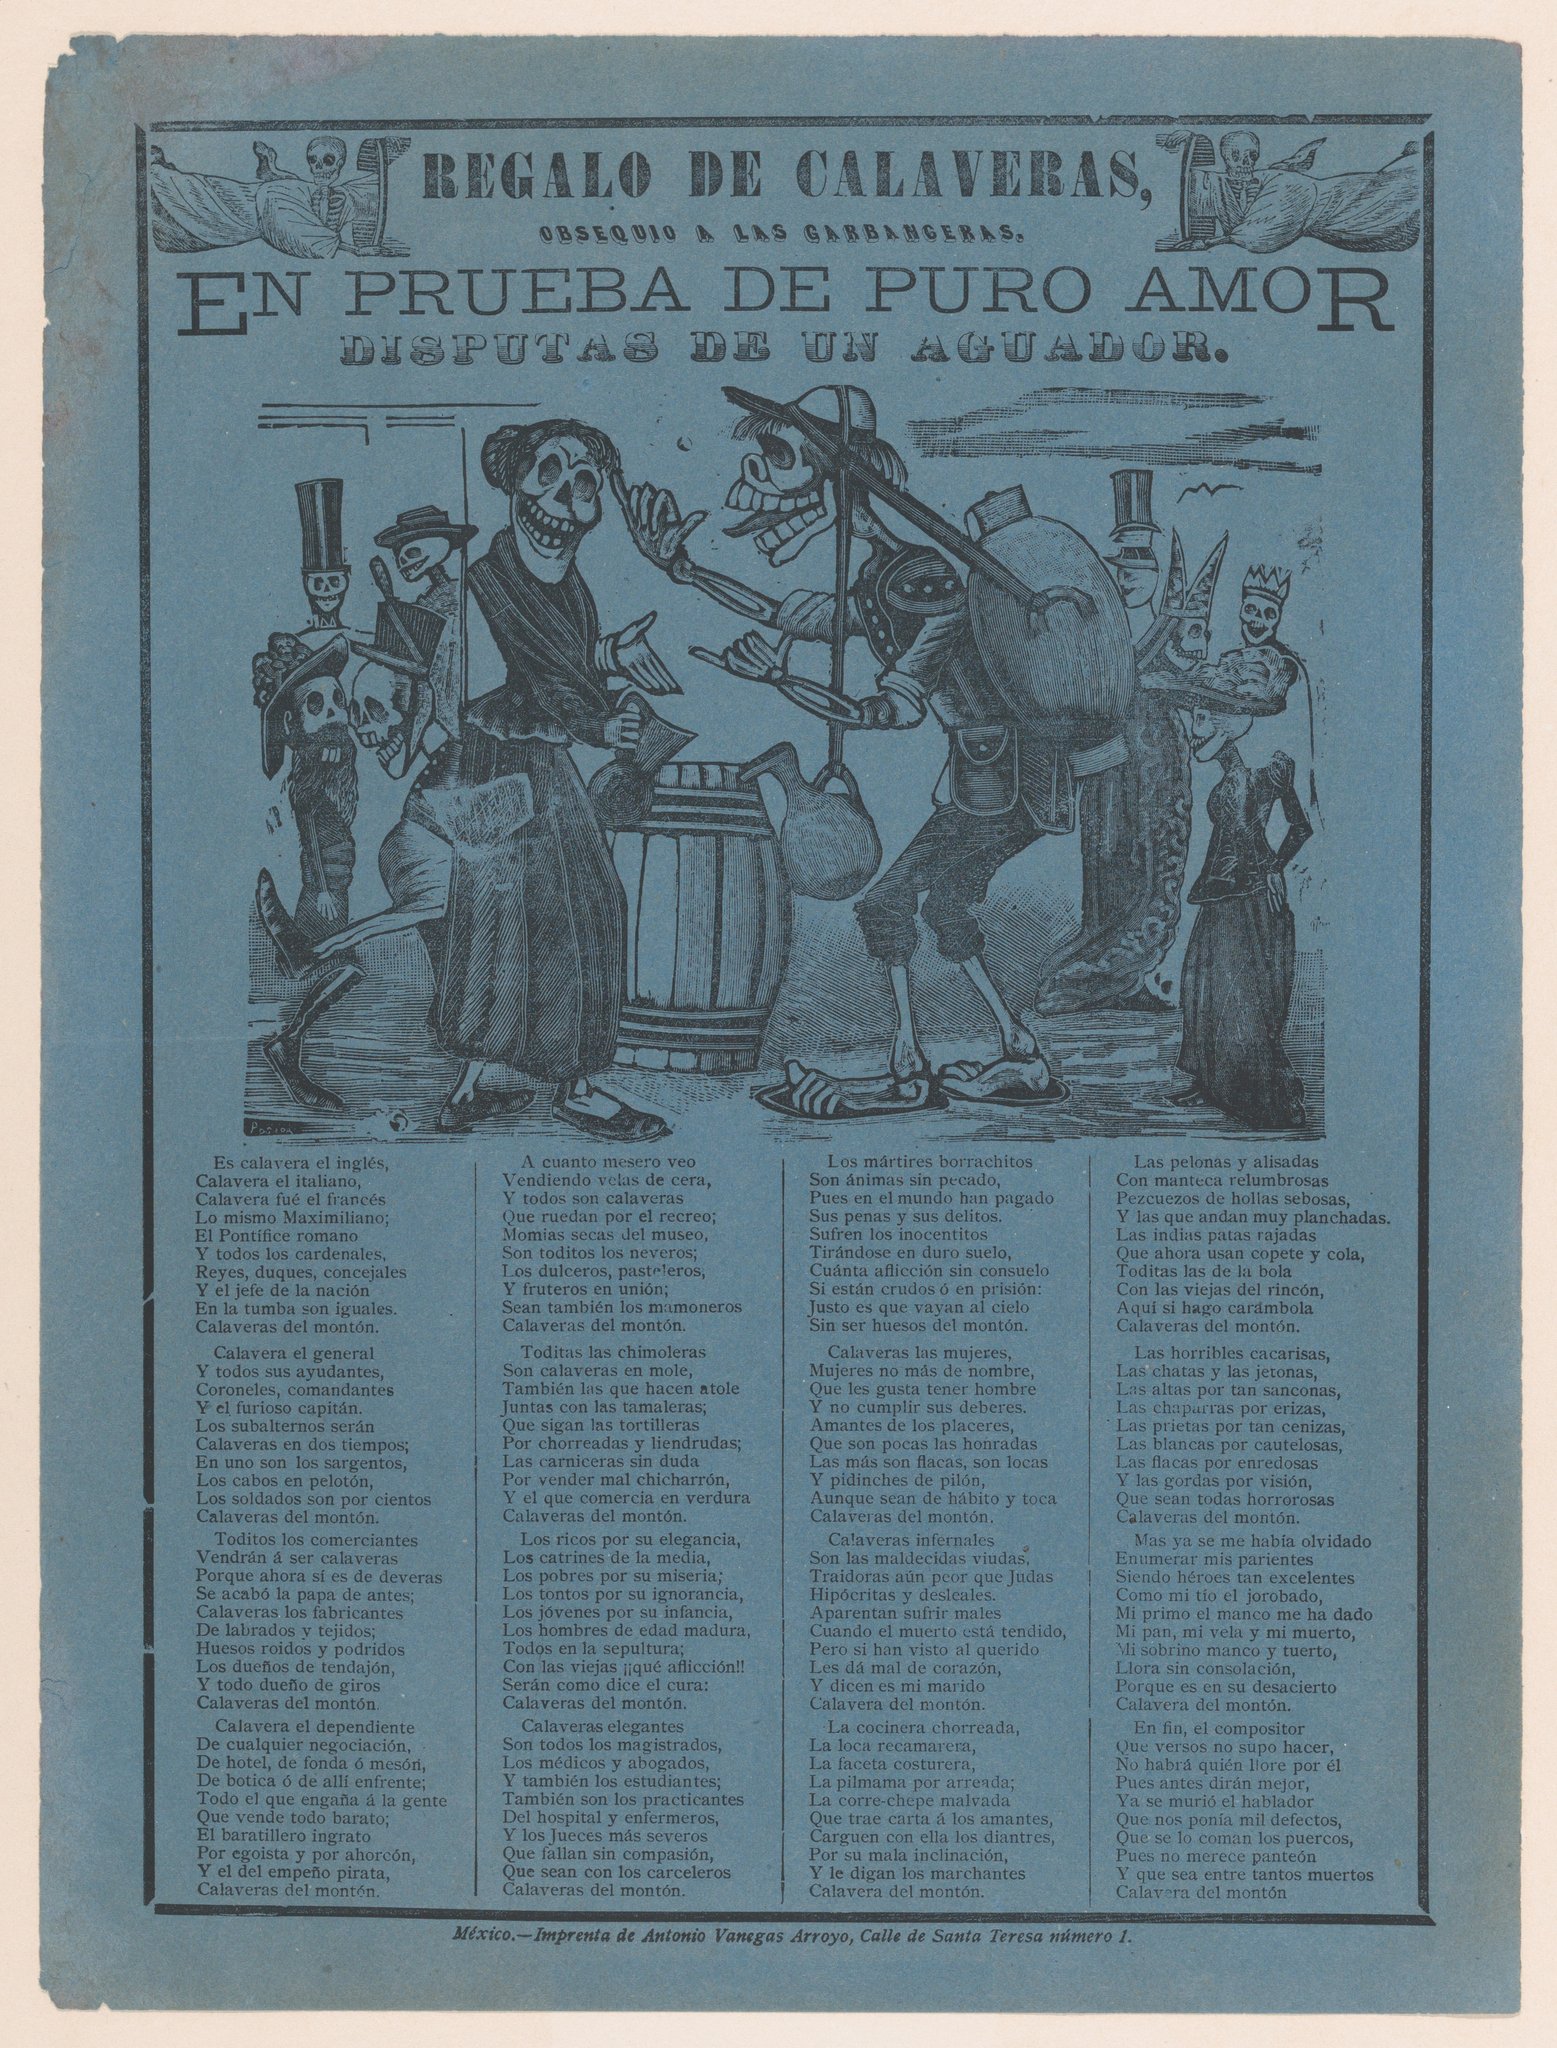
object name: print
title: In proof of true love, a watercarrier skeleton arguing with a woman (Posada); two skeleton angels in upper corners (Manilla)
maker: josé guadalupe posada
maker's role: artist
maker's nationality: mexican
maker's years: 1852-1913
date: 1890-1896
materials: metal, paper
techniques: engraving, letterpress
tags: skeletons,women